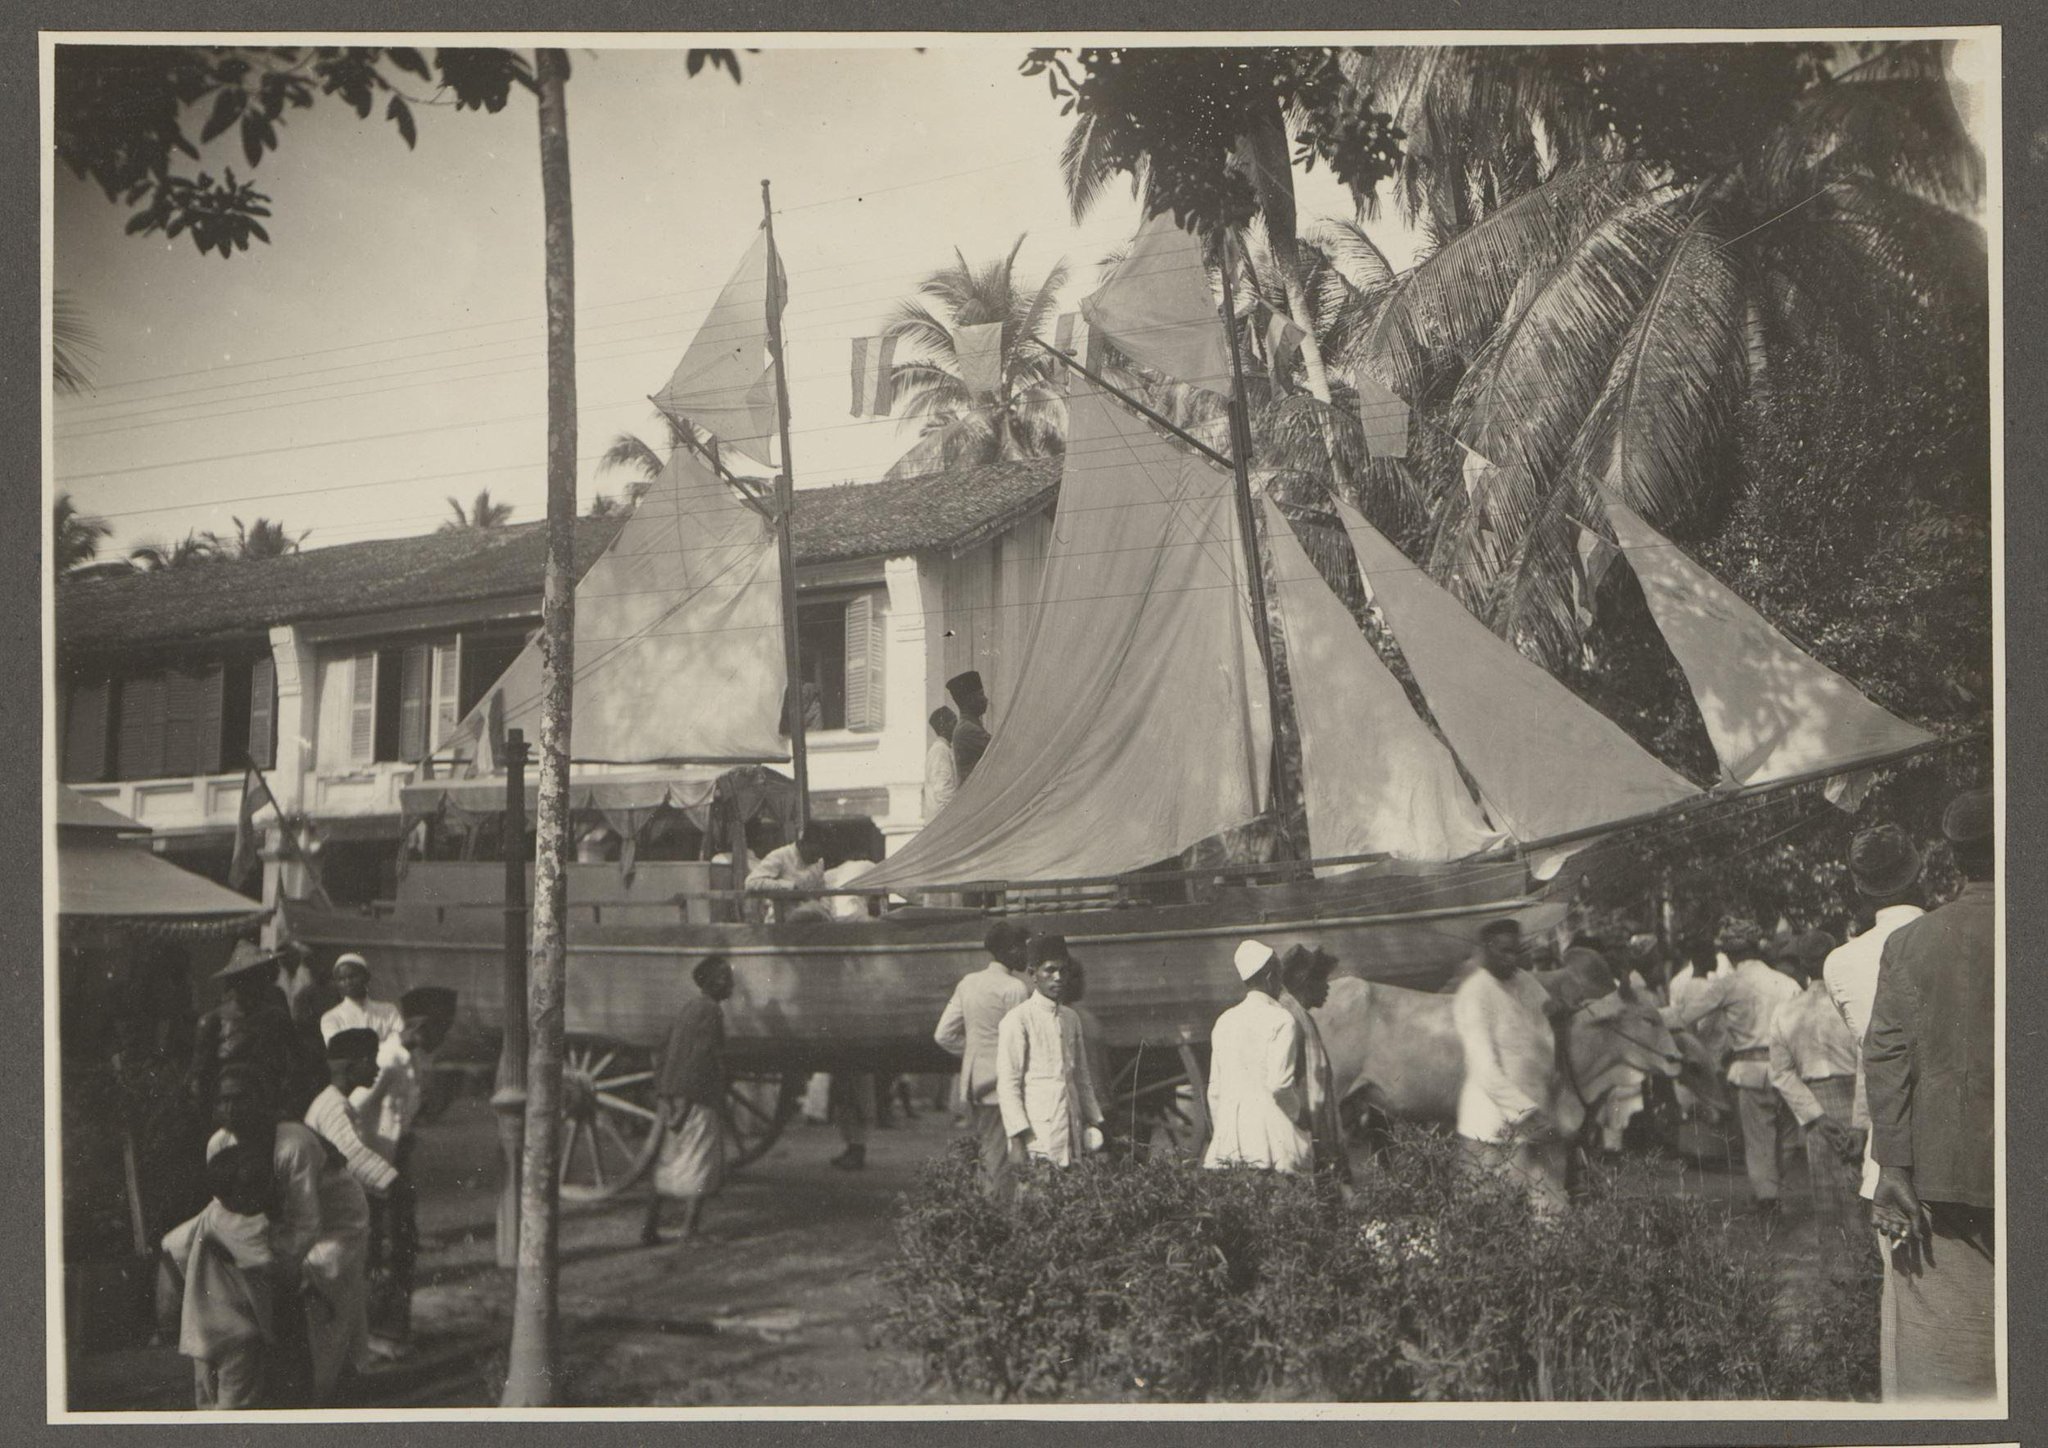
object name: album leaf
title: Mannen met praalwagen van een zeilschip bij het paleis van de Sultan van Langkat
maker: Anonymous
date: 1919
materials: photographic support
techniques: gelatin silver print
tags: float ~ triumph, historical persons, palace, sumatra